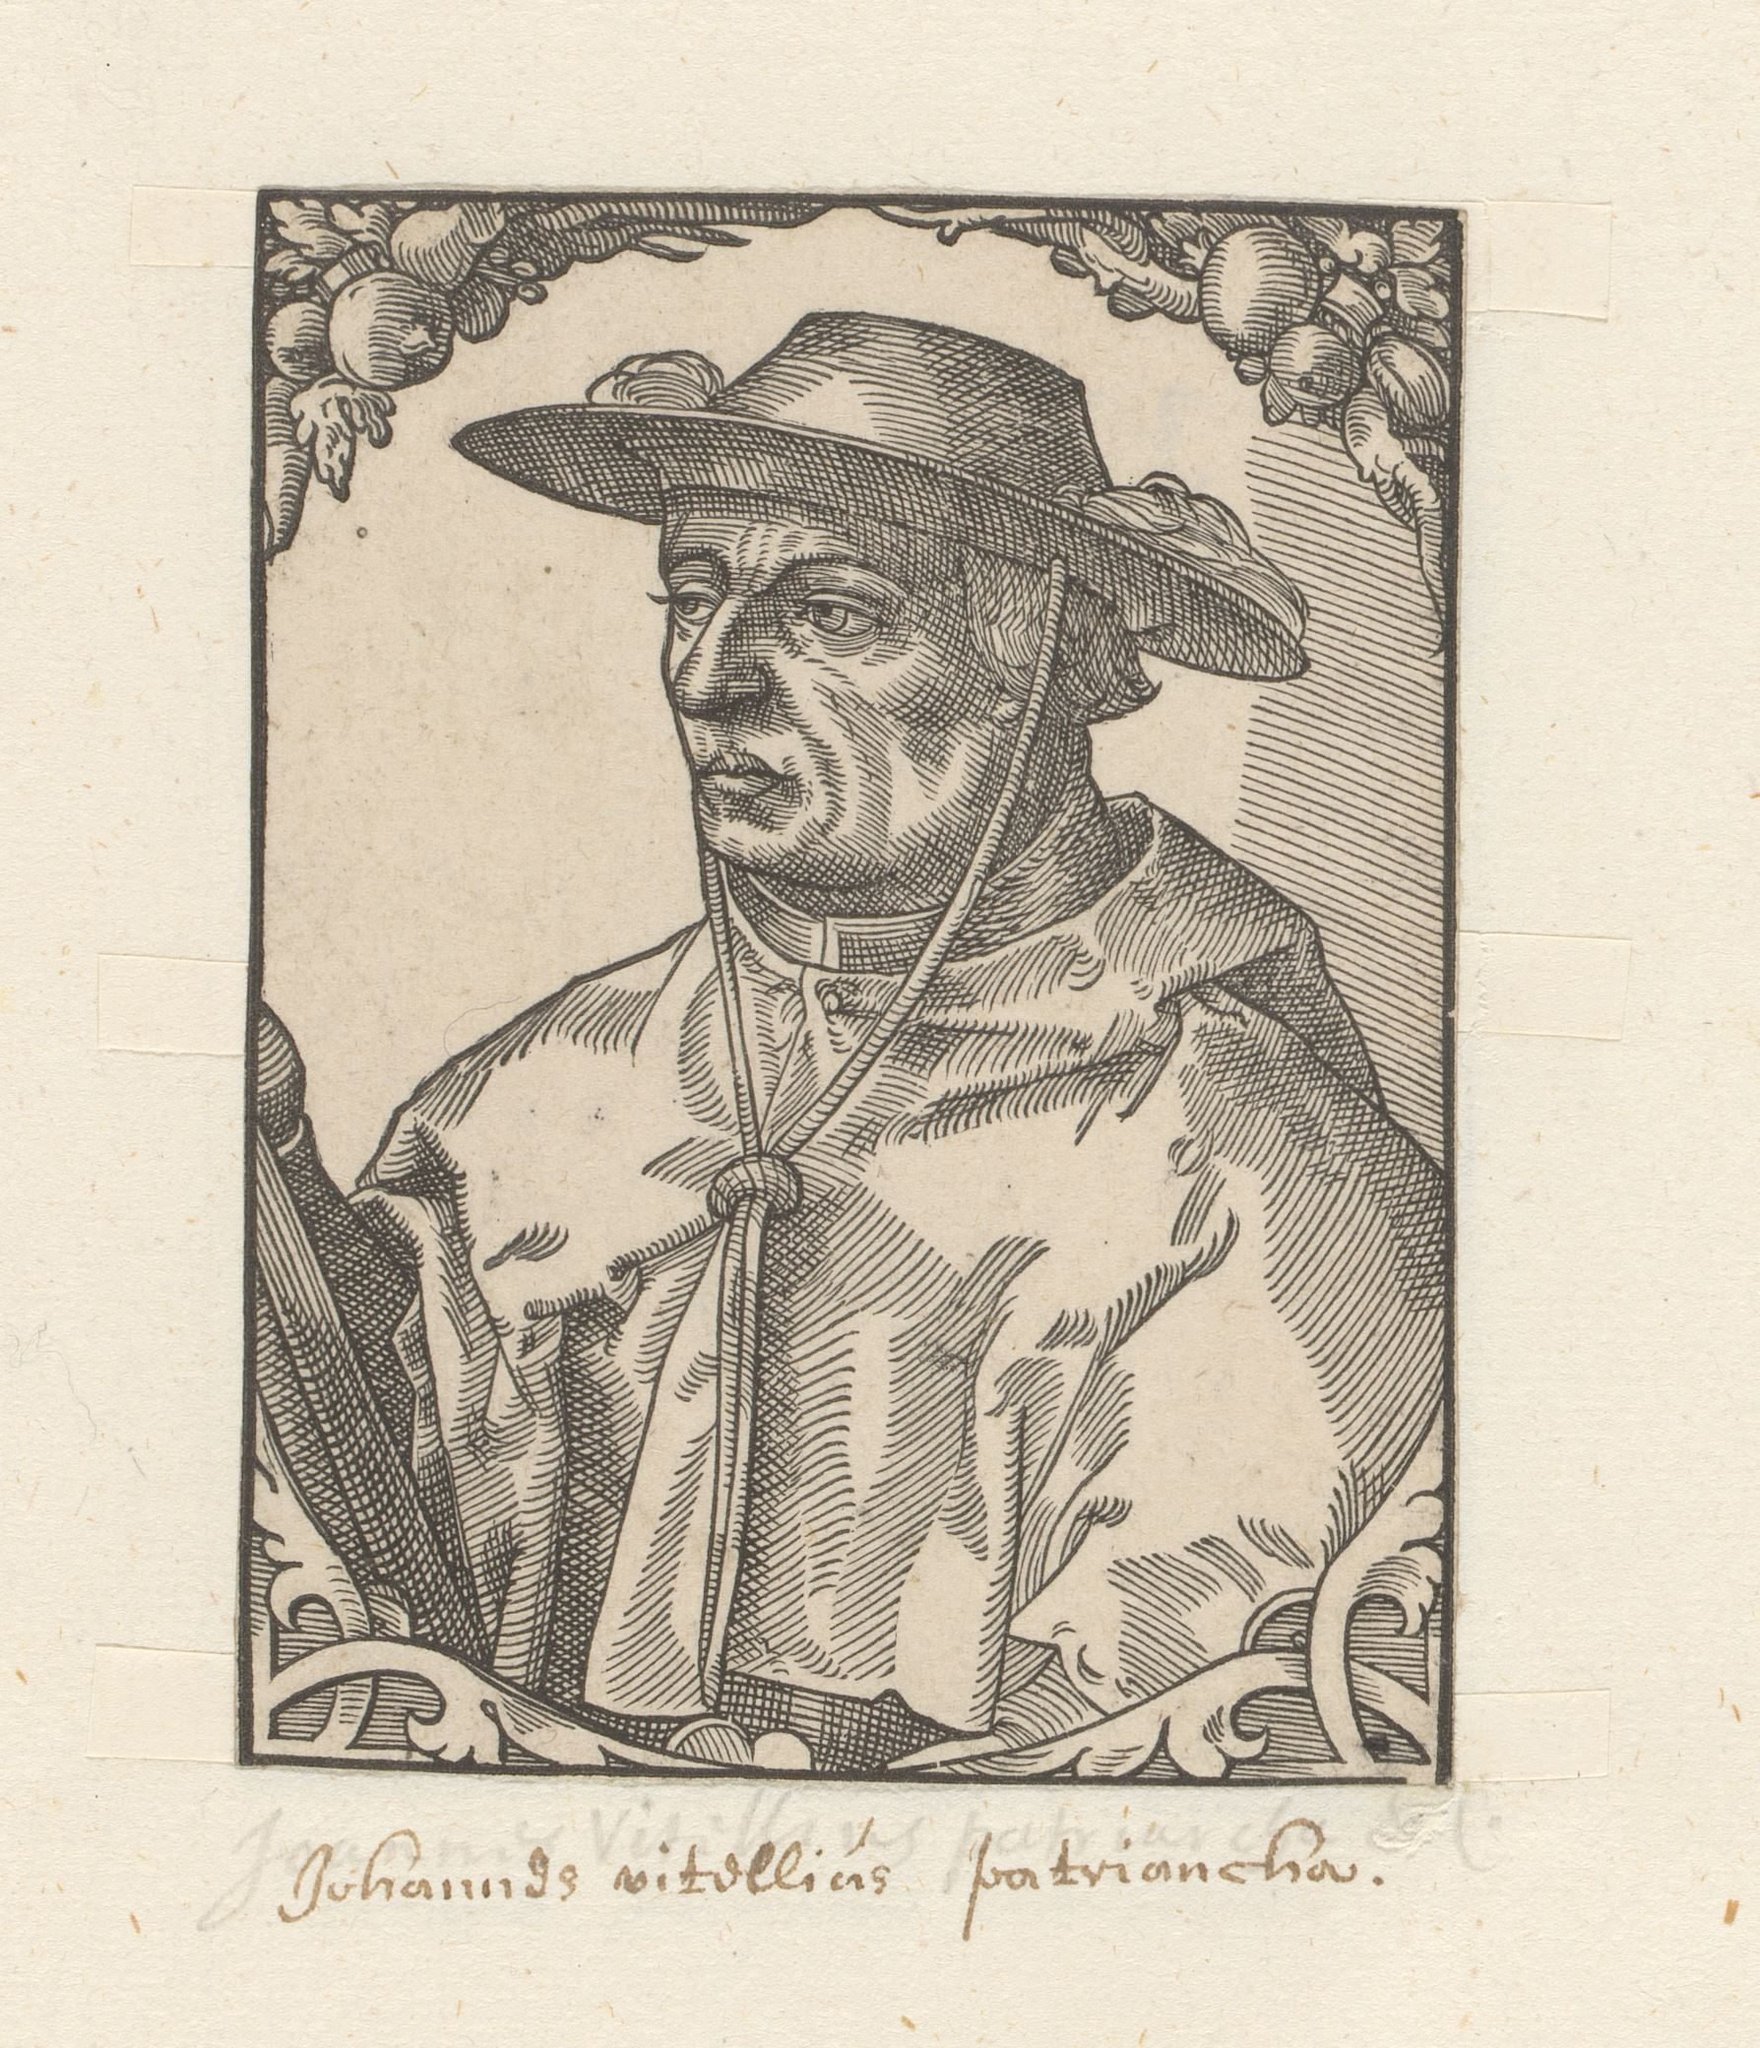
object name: album leaf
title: Portret van Giovanni Vitelleschi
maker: Anonymous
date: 1549-1575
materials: paper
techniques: woodcut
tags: rome, cardinal, historical persons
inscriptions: annotation: ‘Johannes Vitellus Patrianchou’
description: Prent gebruikt in: Giovio, Paolo. Elogia Virorum bellica virtute illustrium (...). Bazel: Peter Perna, 1575.